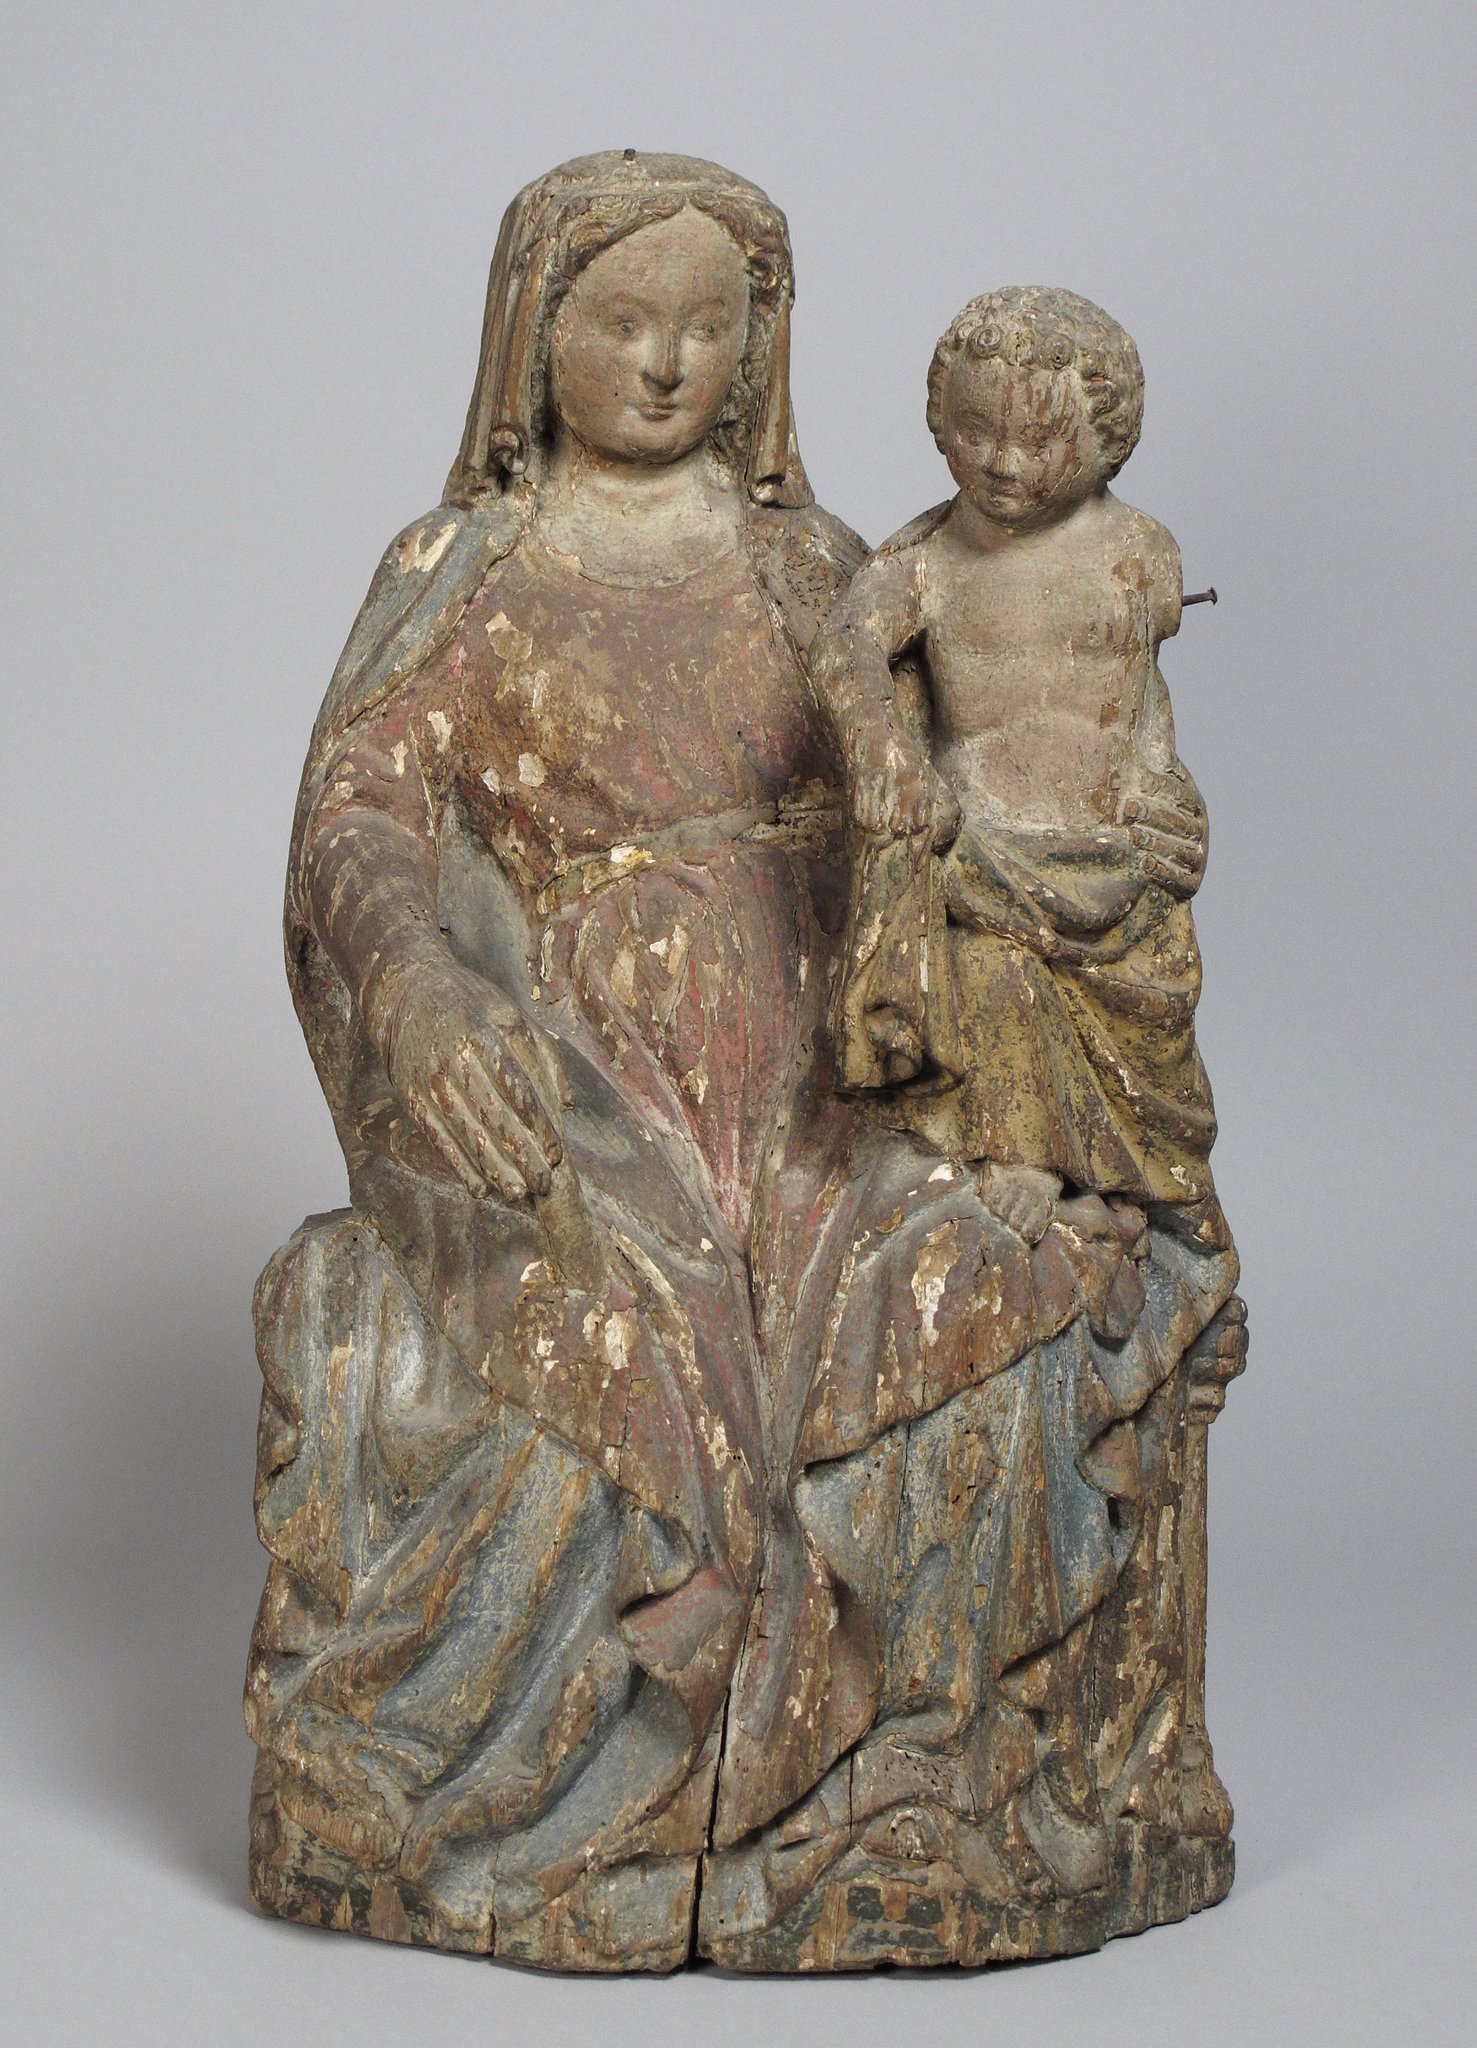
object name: statuette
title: Virgin and Child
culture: french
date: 1301-1400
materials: wood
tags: madonna and child